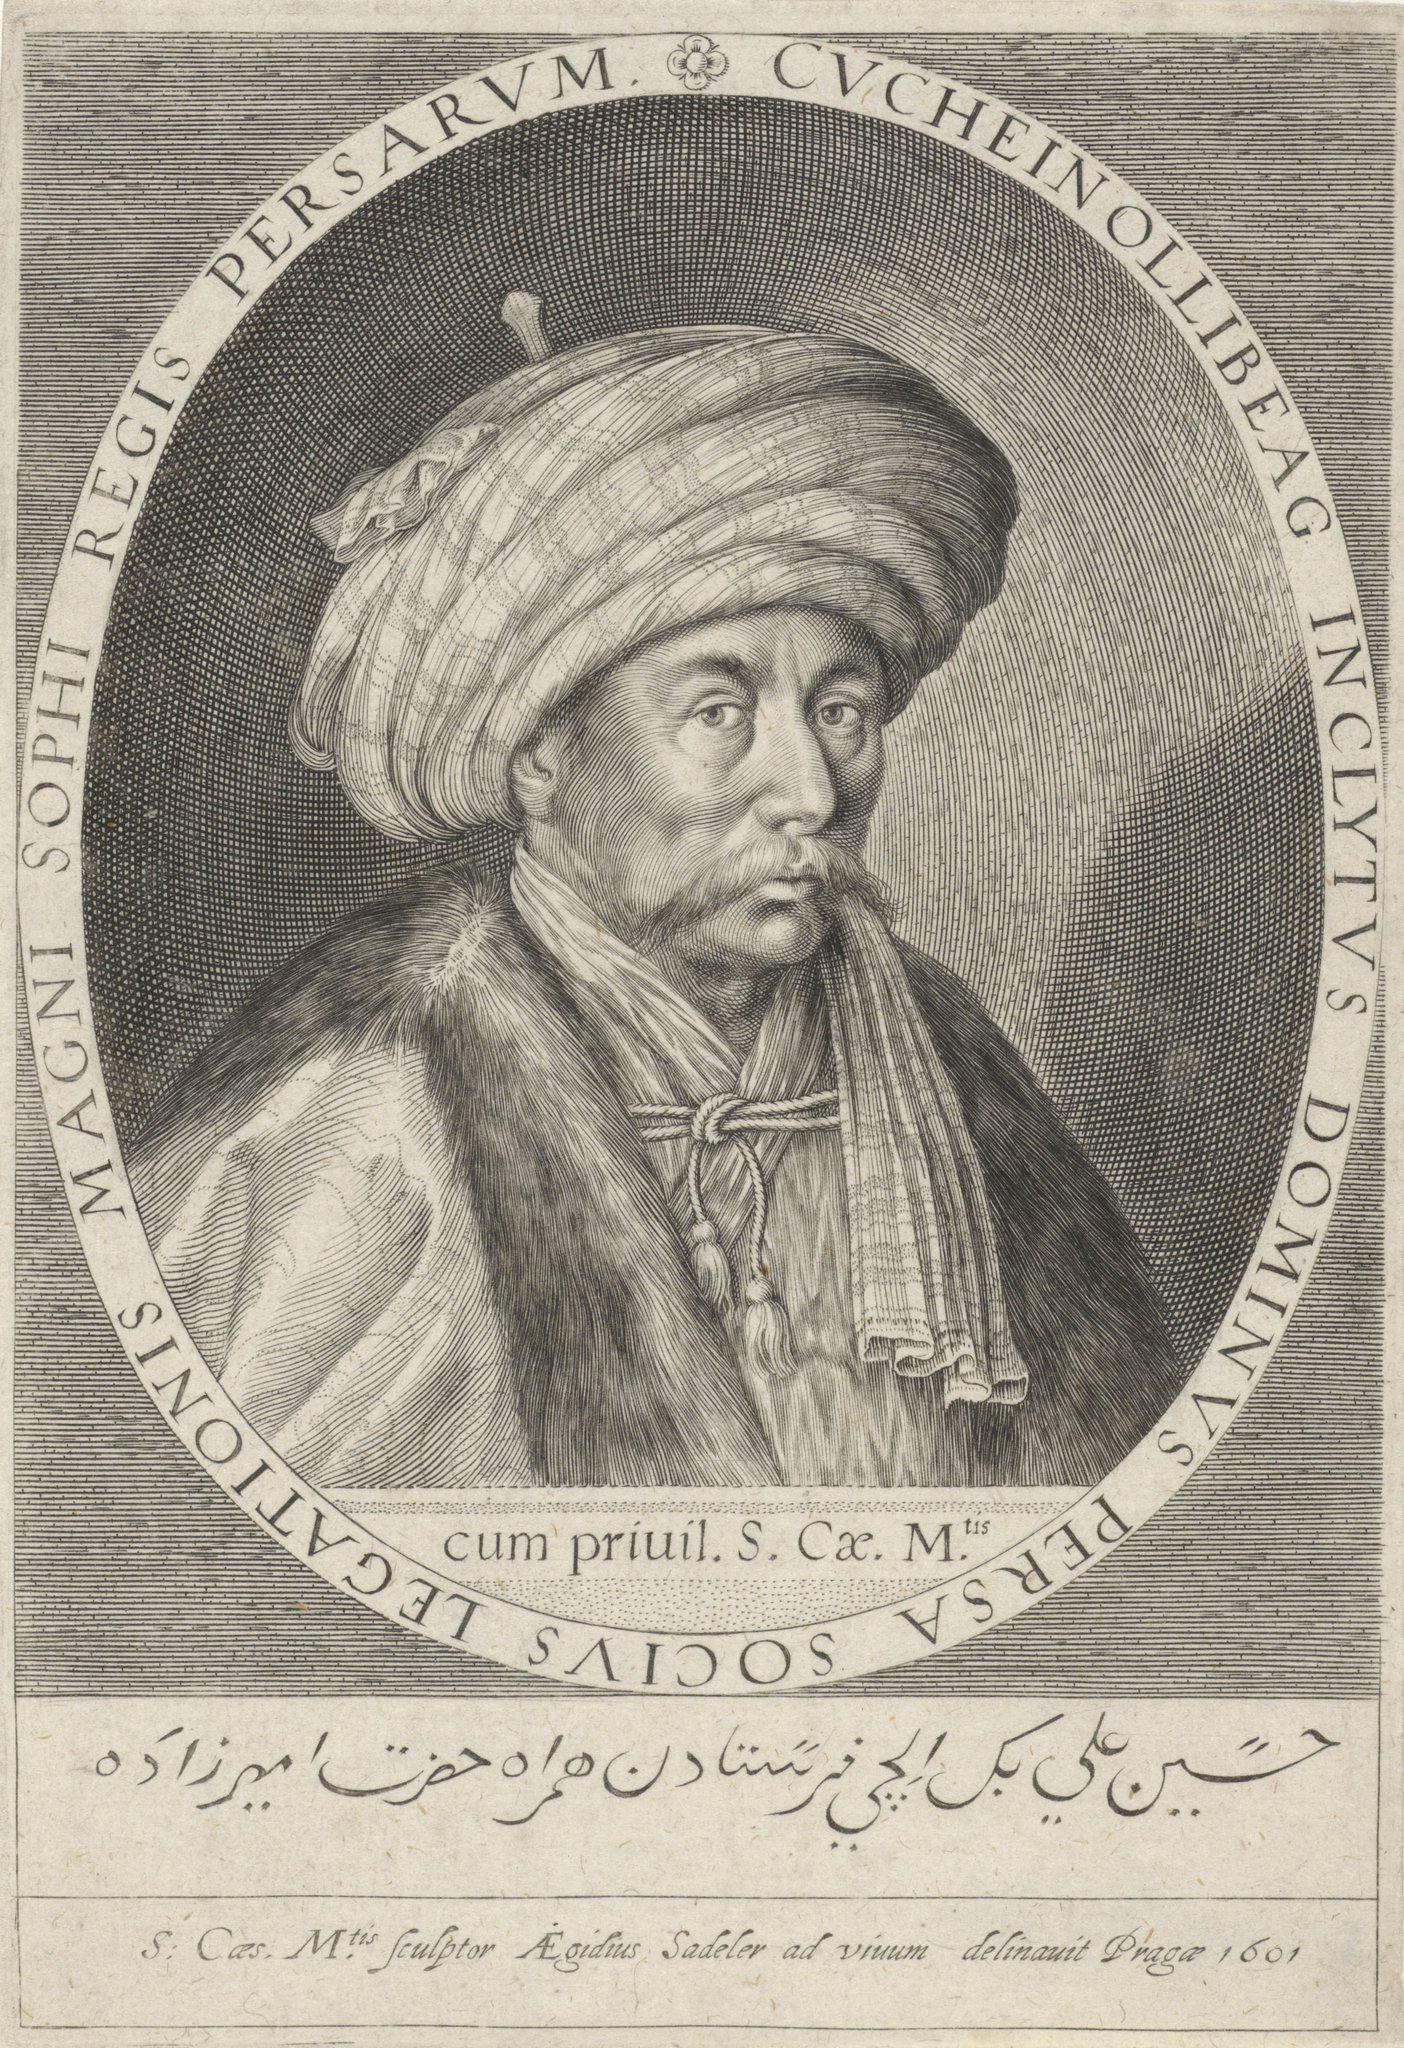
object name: print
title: Portret van Hussein-Ali Bey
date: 1601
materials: paper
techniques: engraving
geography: prague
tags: head-gear: turban, asiatic races and peoples: persians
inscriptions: collector's mark: Lugt 240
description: Hussein-Ali Bey, de Perzisch ambassadeur in Praag rond 1601. Met Arabisch onderschrift.